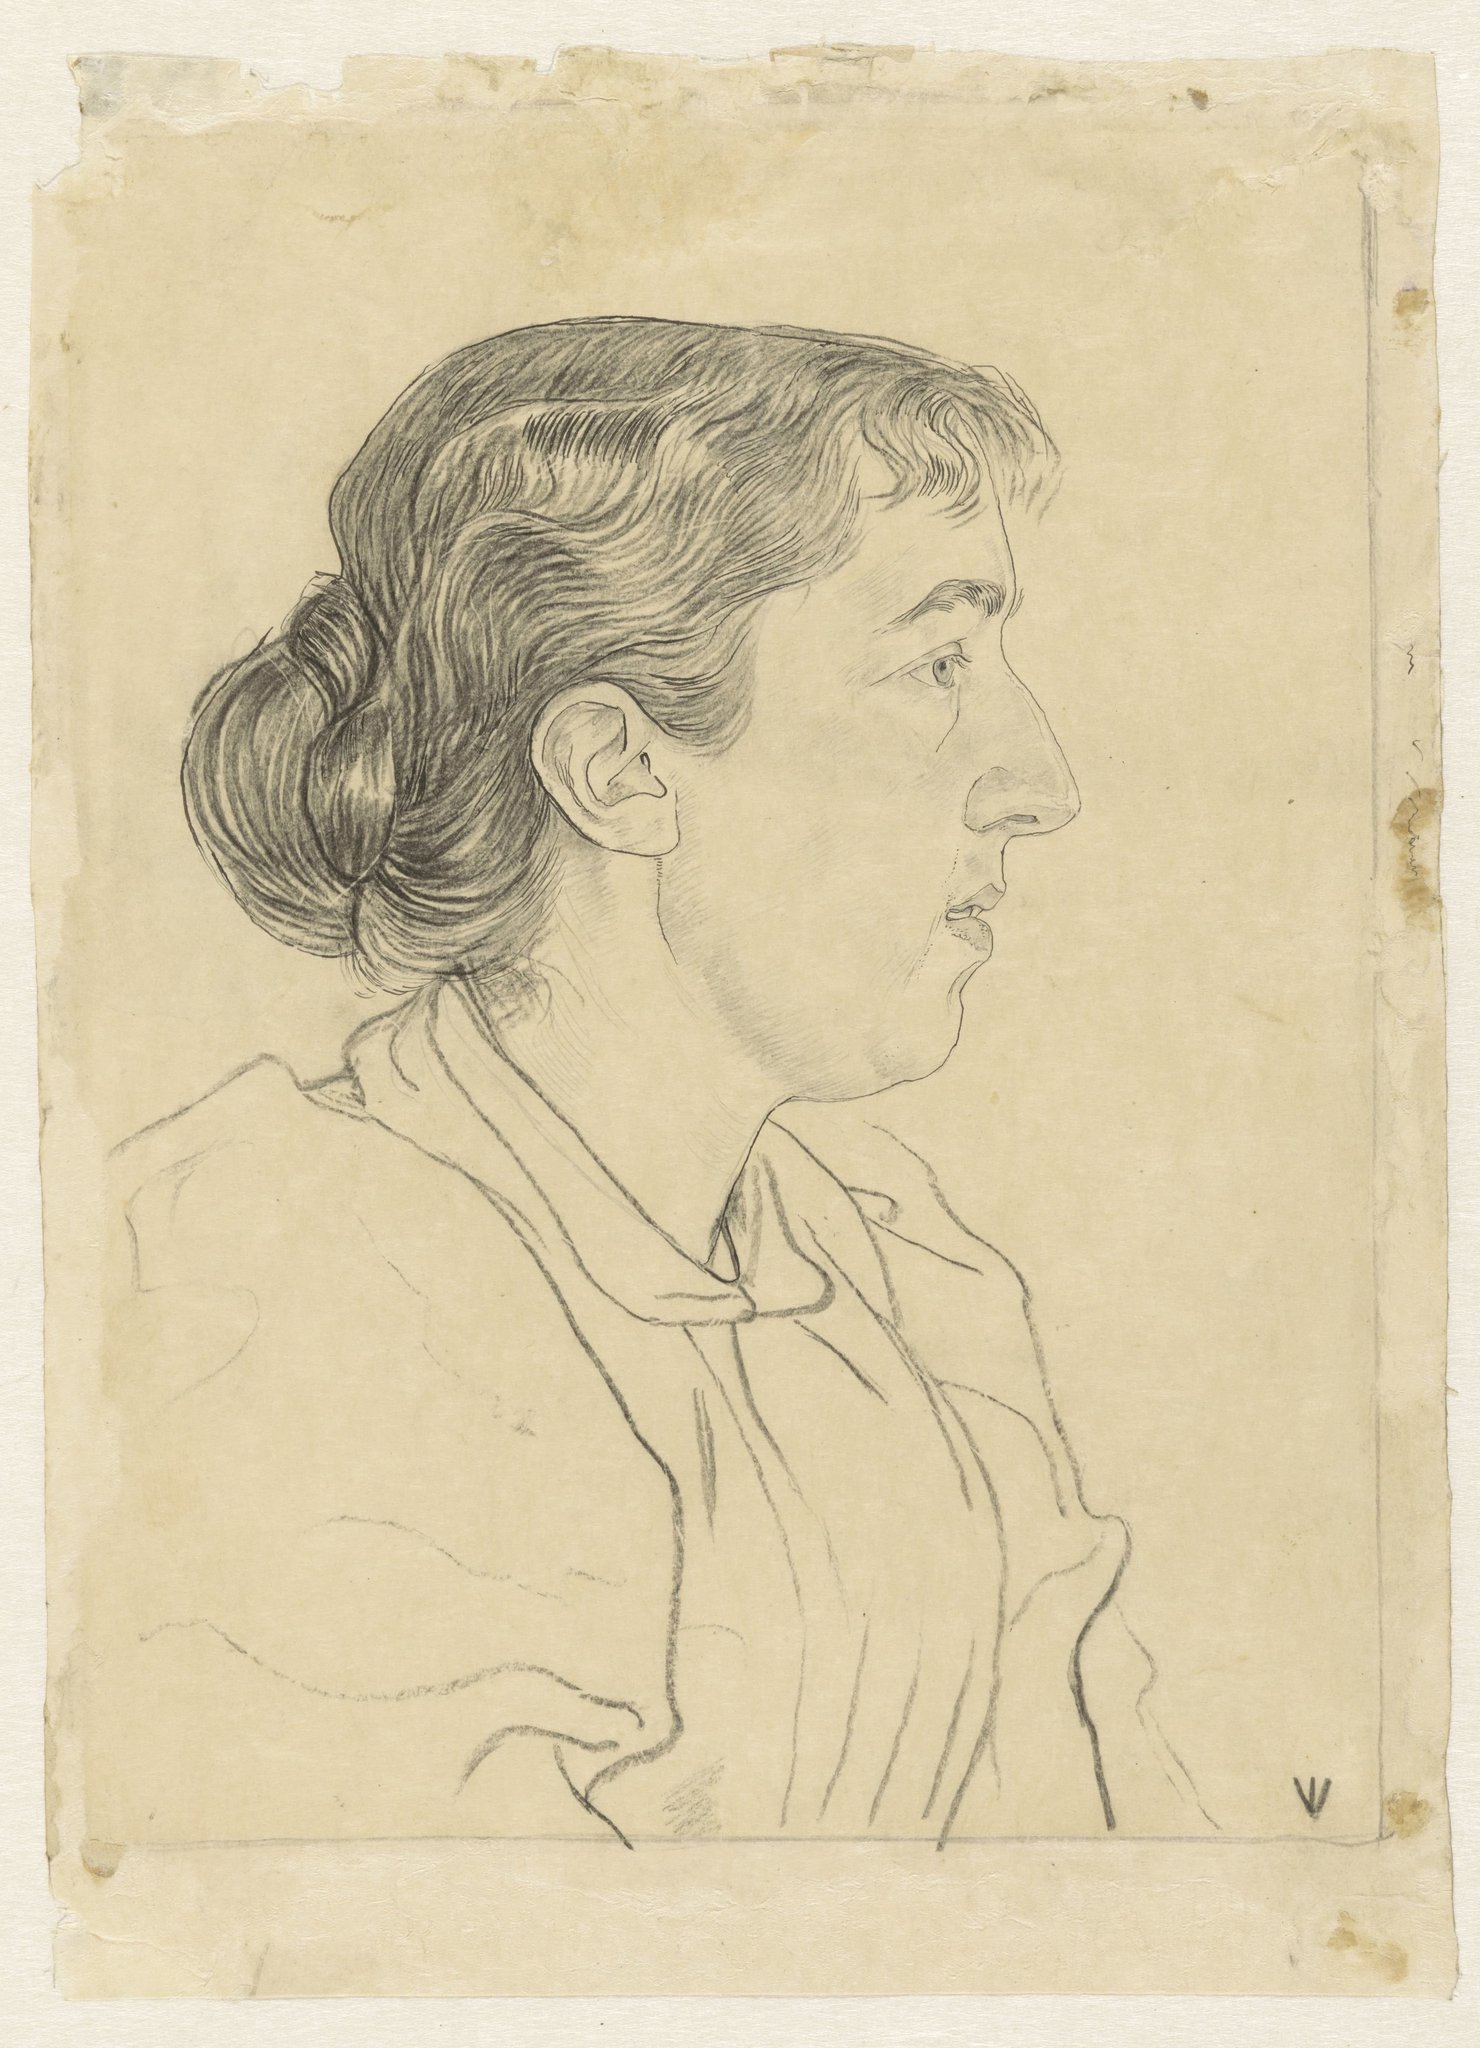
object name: drawing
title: Portret van Helène Lapidoth-Swarth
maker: jan veth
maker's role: designer, draughtsman, painter, print maker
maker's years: 1864-1925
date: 1874-1925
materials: chalk, ink, paper, pencil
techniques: pen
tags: amsterdam, hélène swarth, historical persons - bb - woman